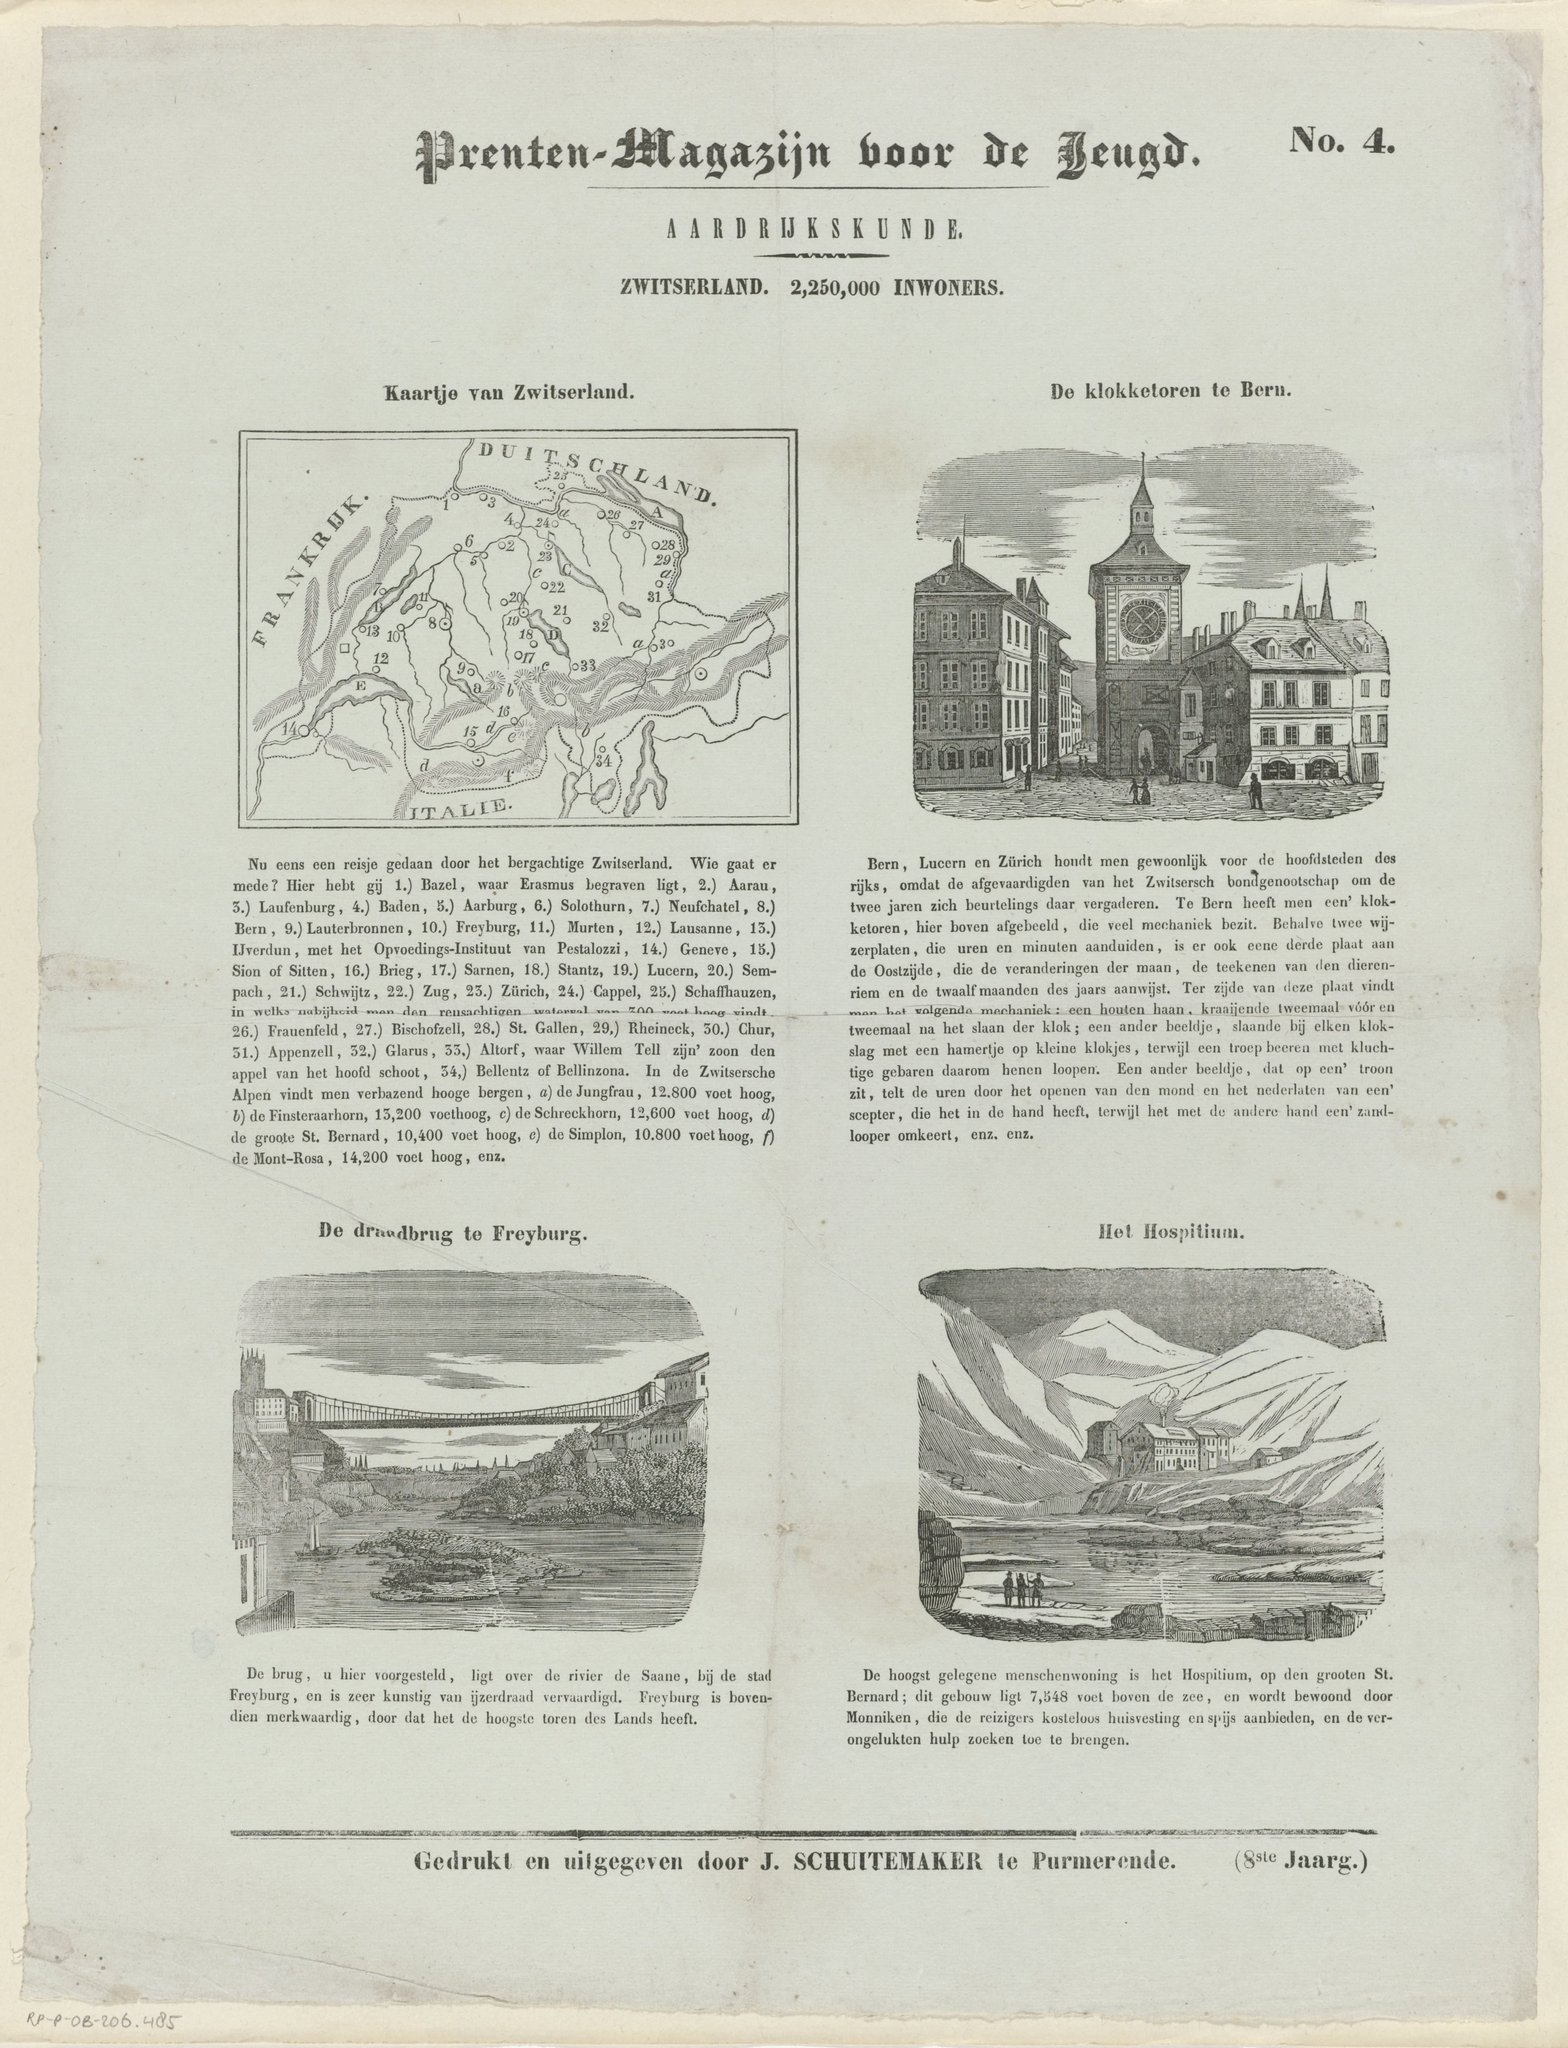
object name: popular print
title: Prenten-magazijn voor de jeugd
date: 1849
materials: paper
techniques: letterpress printing, engraving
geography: netherlands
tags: maps, atlases, switzerland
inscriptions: collector's mark: Lugt 2760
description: Blad met 4 voorstellingen over Zwitserland met een kaart en belangrijke monumenten en steden: de klokkentoren te Bern, een brug in Fribourg en het klooster van St. Bernard. Boven elke voorstelling een titel en onder elke voorstelling een onderschrift. Genummerd rechtsboven: No. 4.